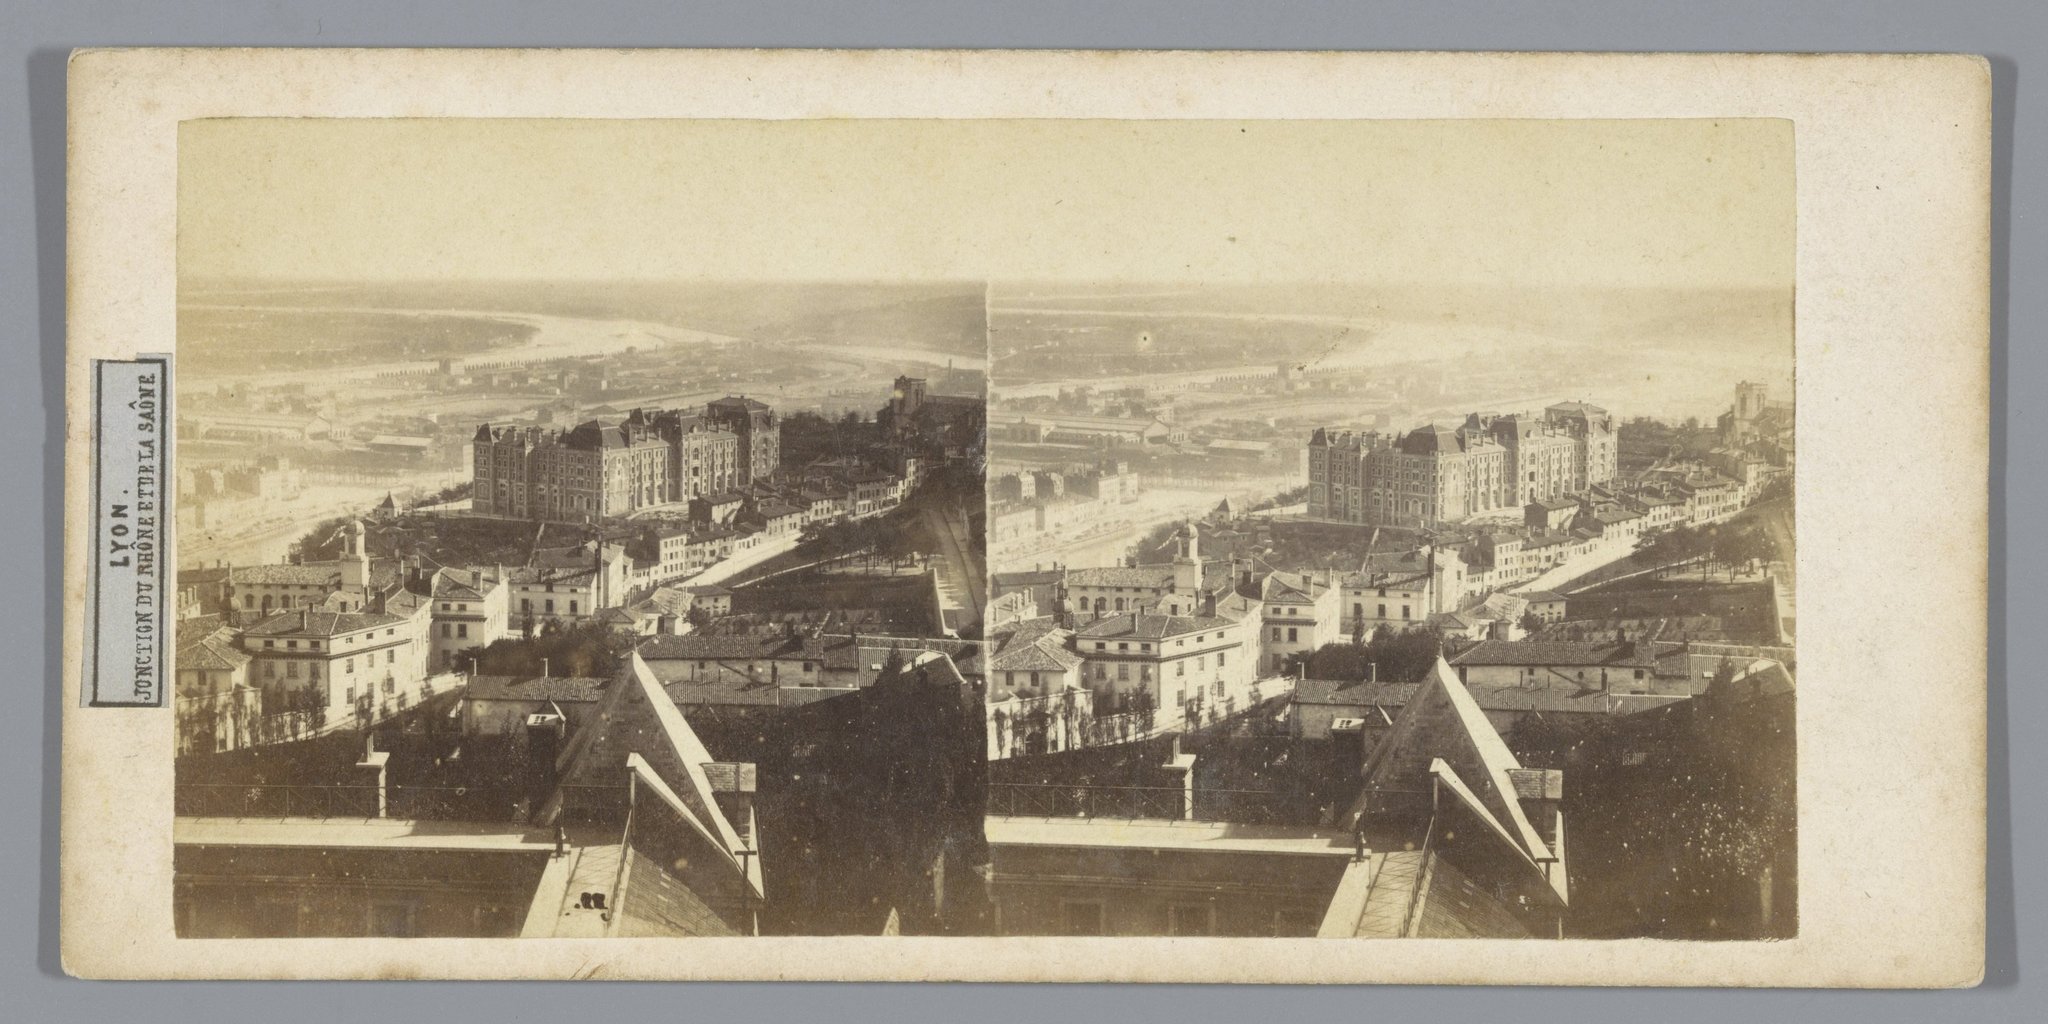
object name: stereograph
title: Gezicht op Lyon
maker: fourvières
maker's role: fotograaf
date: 1855-1865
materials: cardboard, photographic support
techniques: albumen print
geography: lyon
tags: lyon